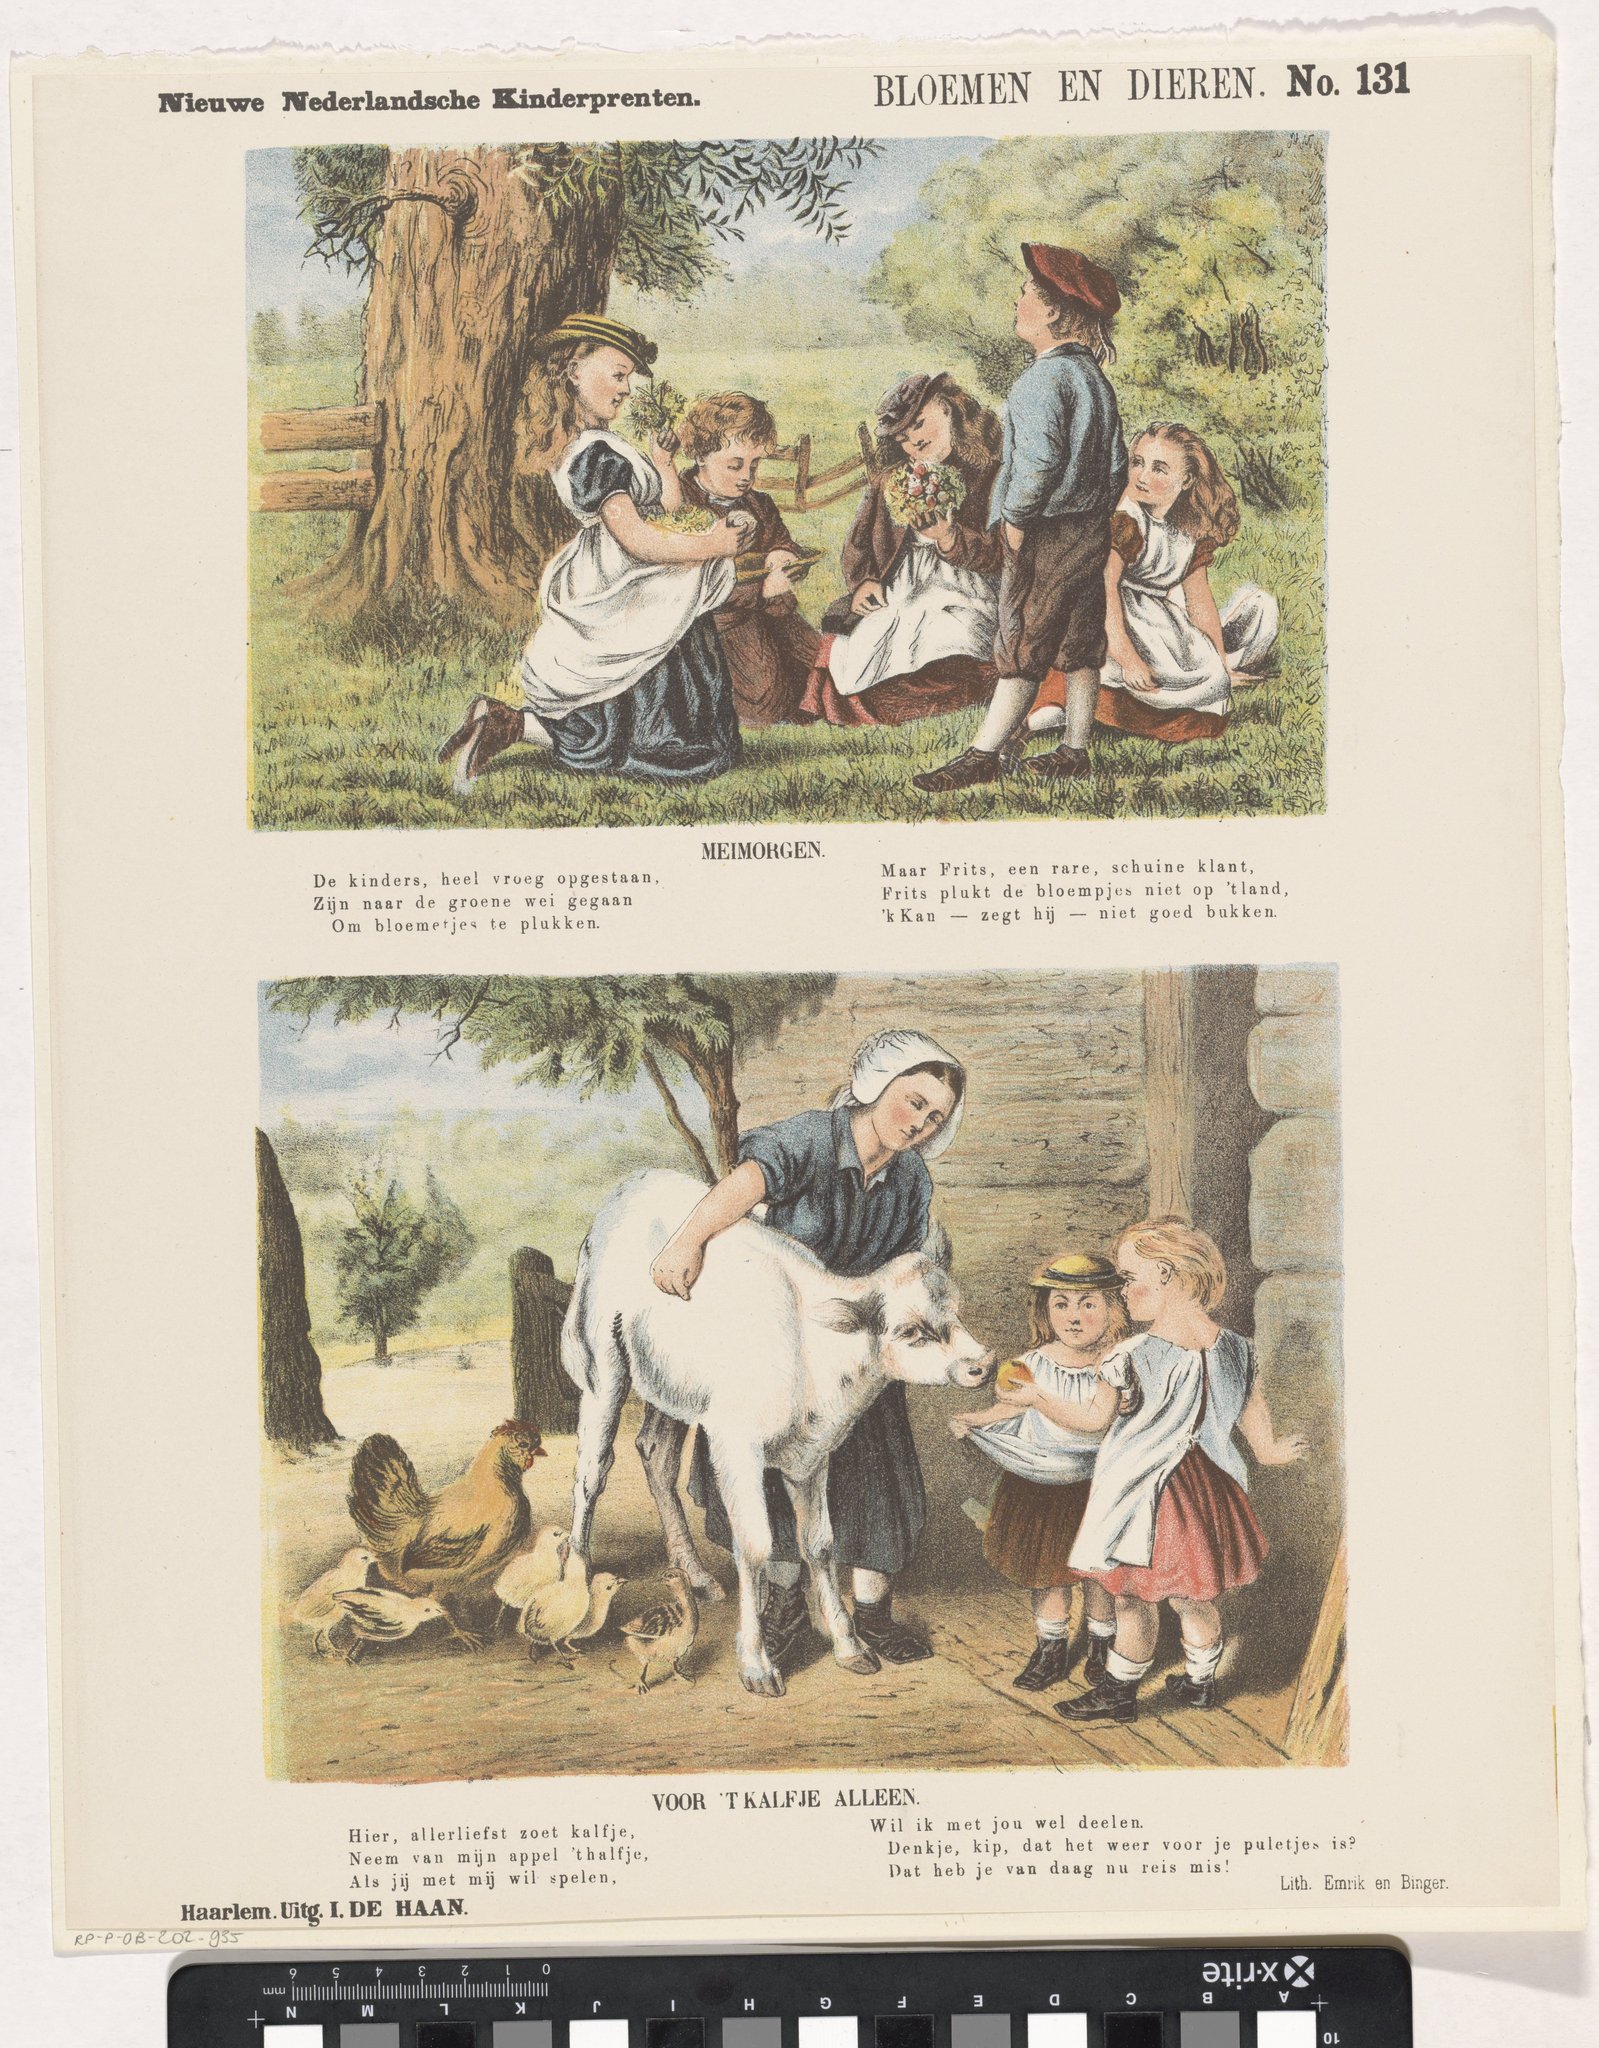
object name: print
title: Bloemen en dieren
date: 1875-1903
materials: paper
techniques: lithograph, letterpress printing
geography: haarlem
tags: picking flowers, calf, meadow, pasture (+ landscape with figures, staffage)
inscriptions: collector's mark: Lugt 2760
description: Blad met 2 voorstellingen. Boven: een groepje kinderen dat bloemen plukt in een weiland. Onder: kinderen die een kalf een appel voeren. Onder elke afbeelding een vers. Genummerd rechtsboven: No. 131.